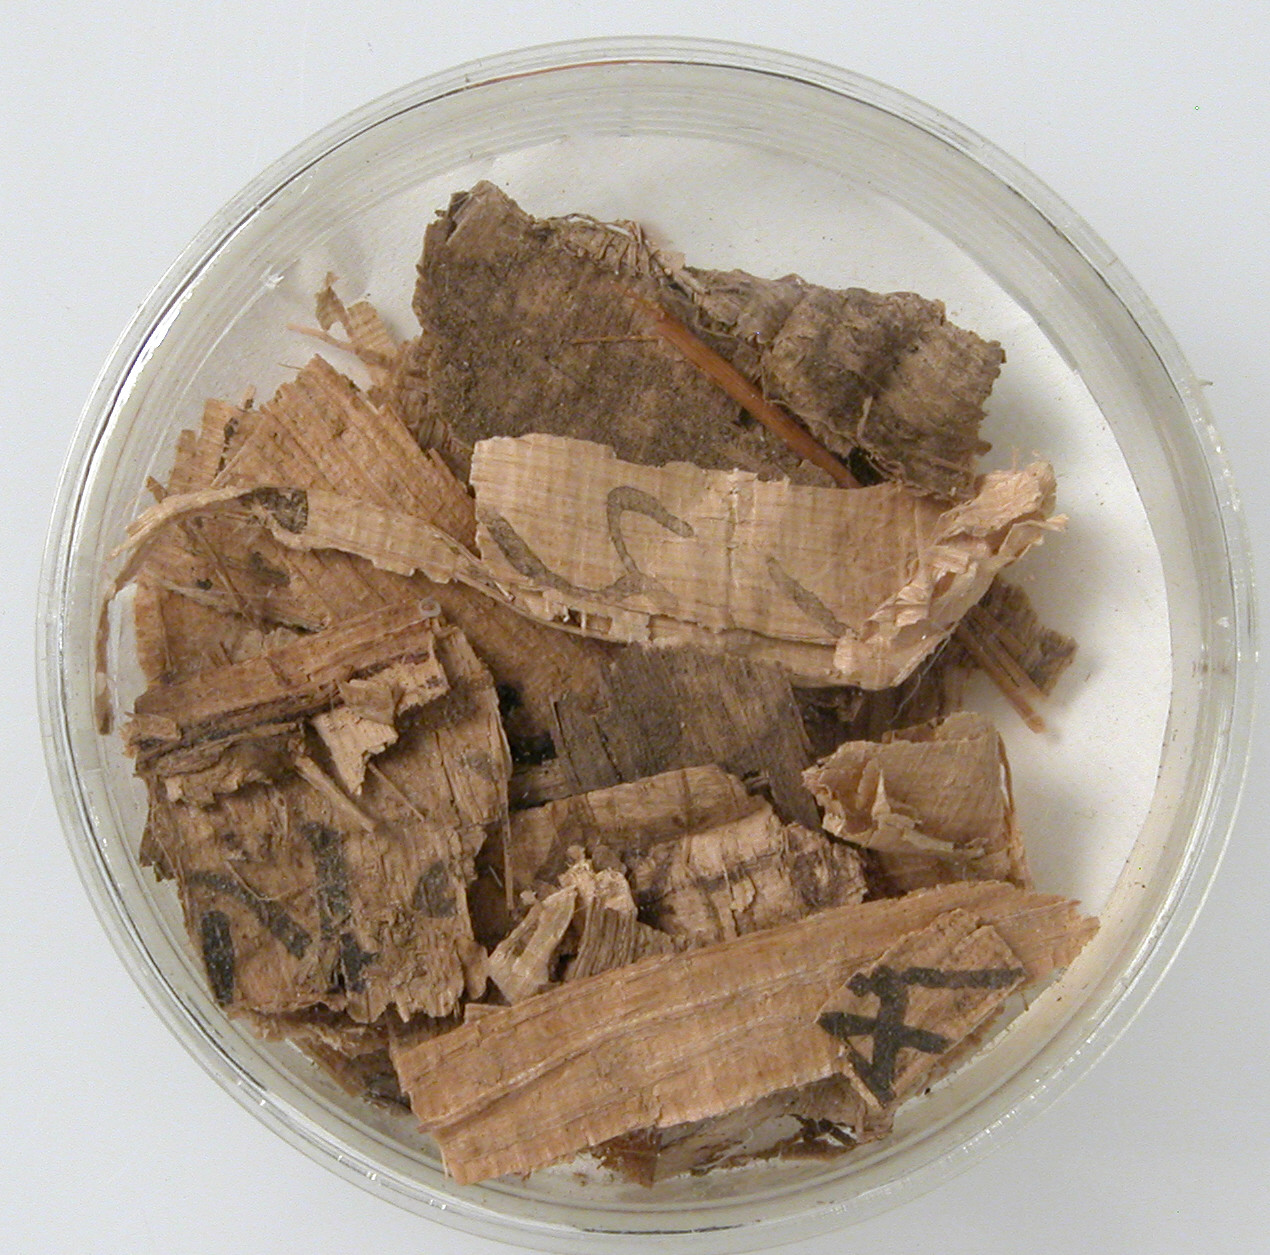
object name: fragment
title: Papyri Fragments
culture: coptic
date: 601-700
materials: ink, papyrus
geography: egypt